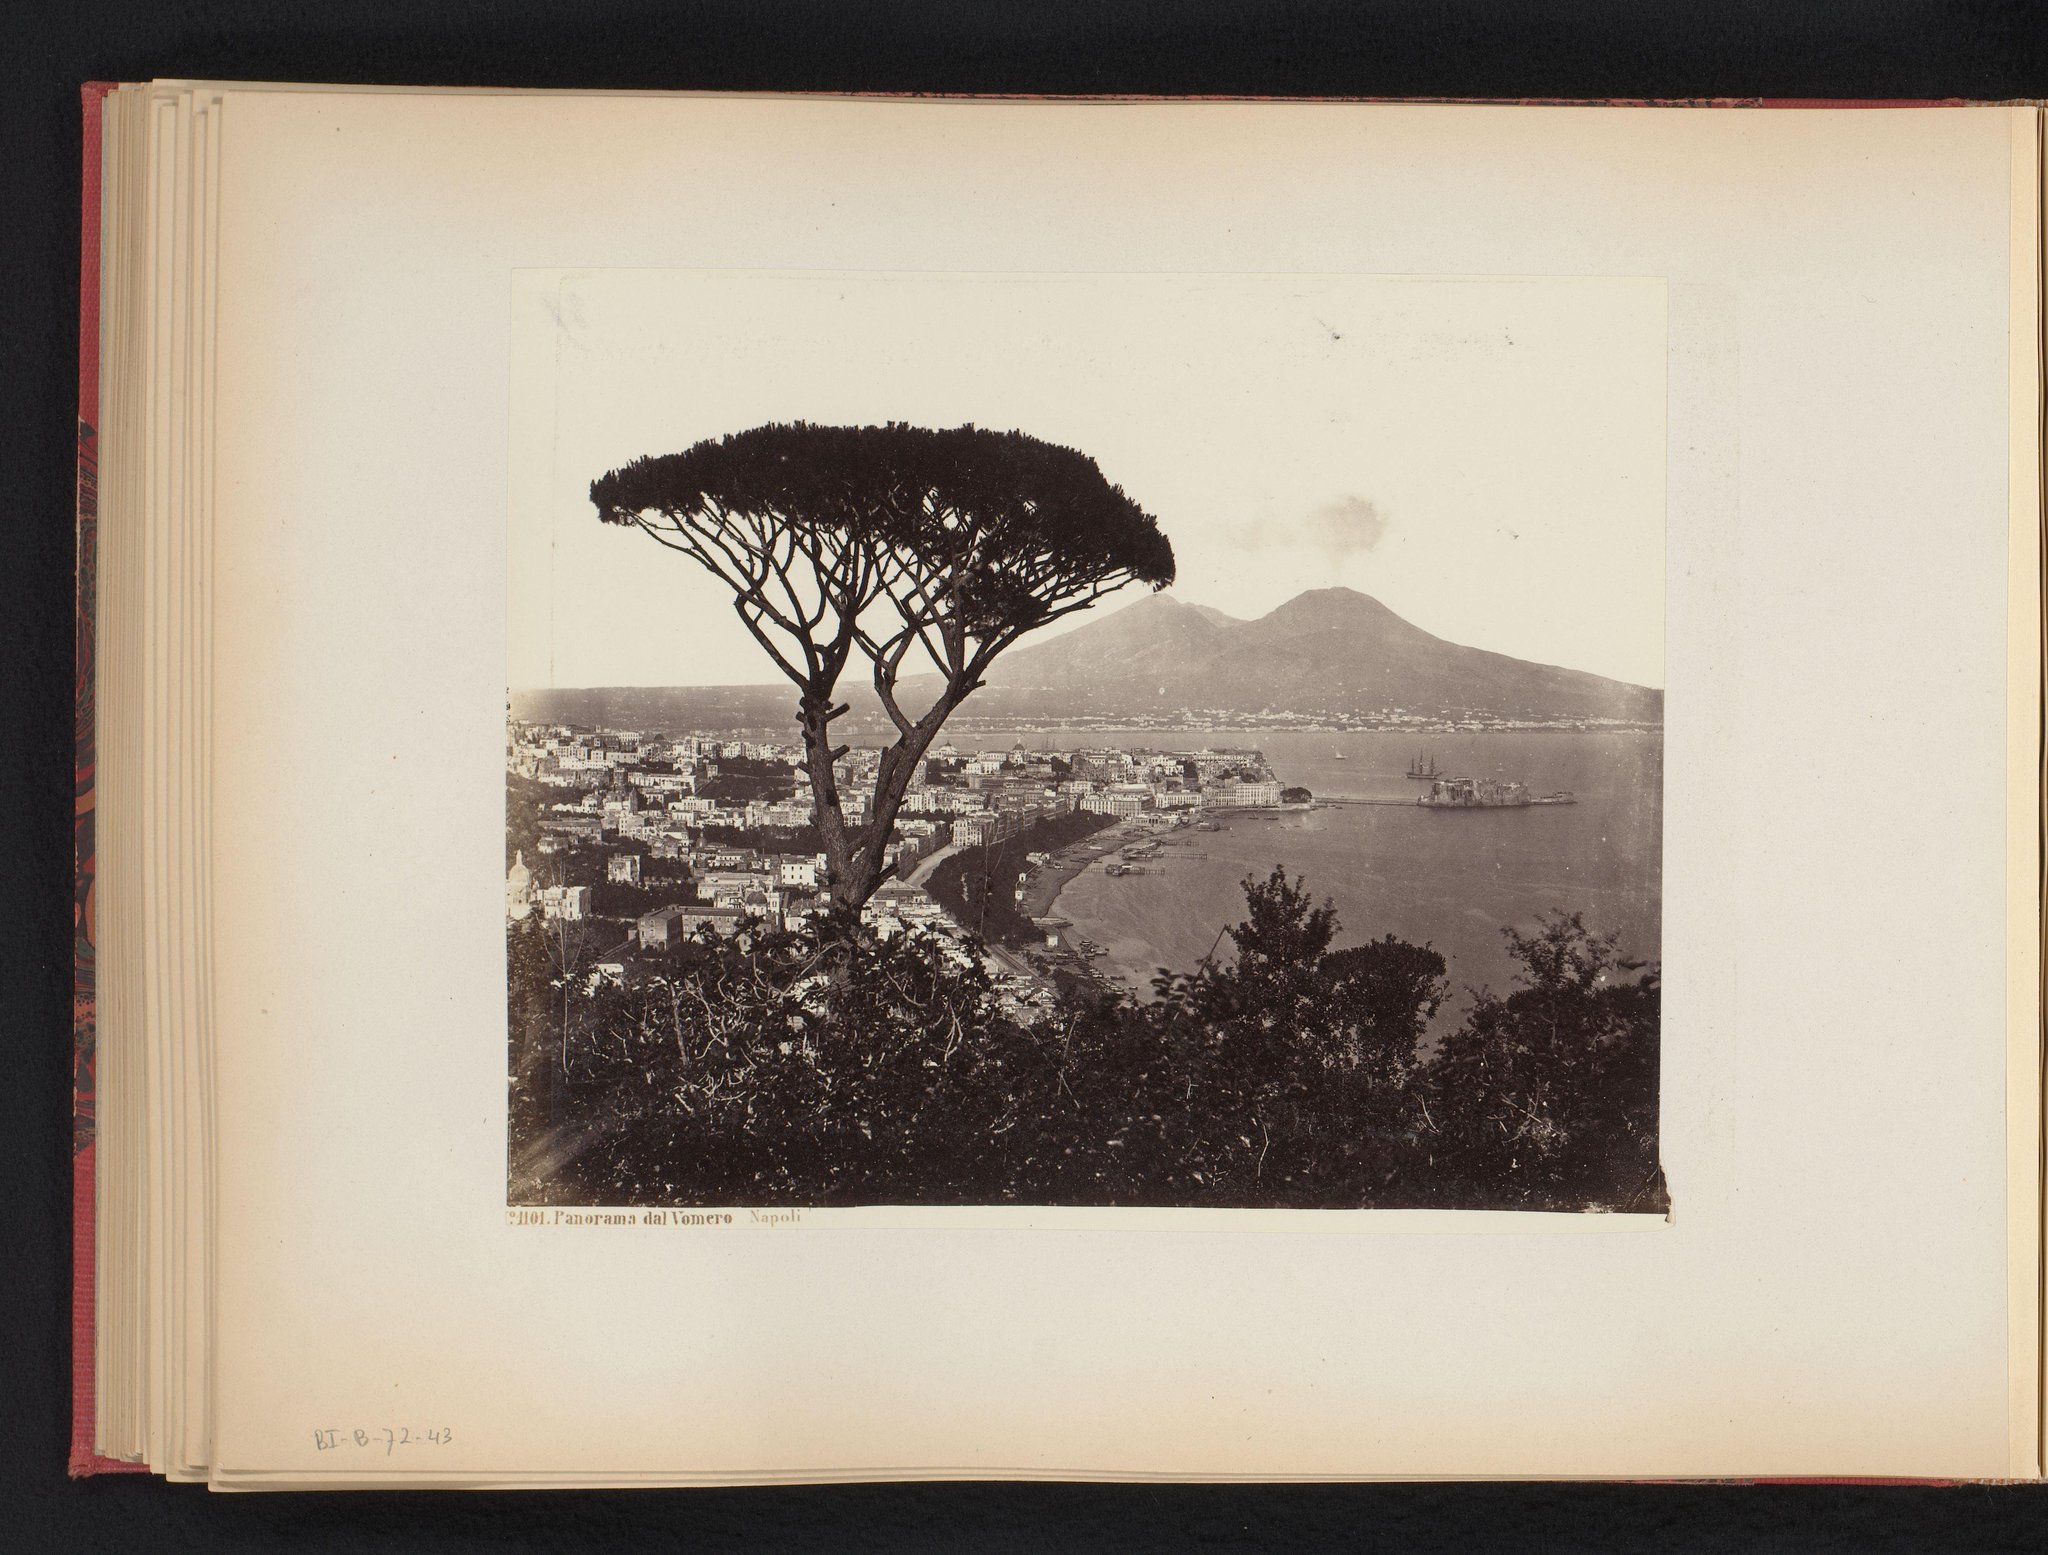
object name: photograph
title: Gezicht op Napels, Italië, met een pijnboom op de voorgrond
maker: giorgio sommer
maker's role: fotograaf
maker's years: 1834-1914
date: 1870-1890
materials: paper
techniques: albumen print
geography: naples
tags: trees, city-view in general; 'veduta', volcano, mount vesuvius, naples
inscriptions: number: ‘No. 1101.’